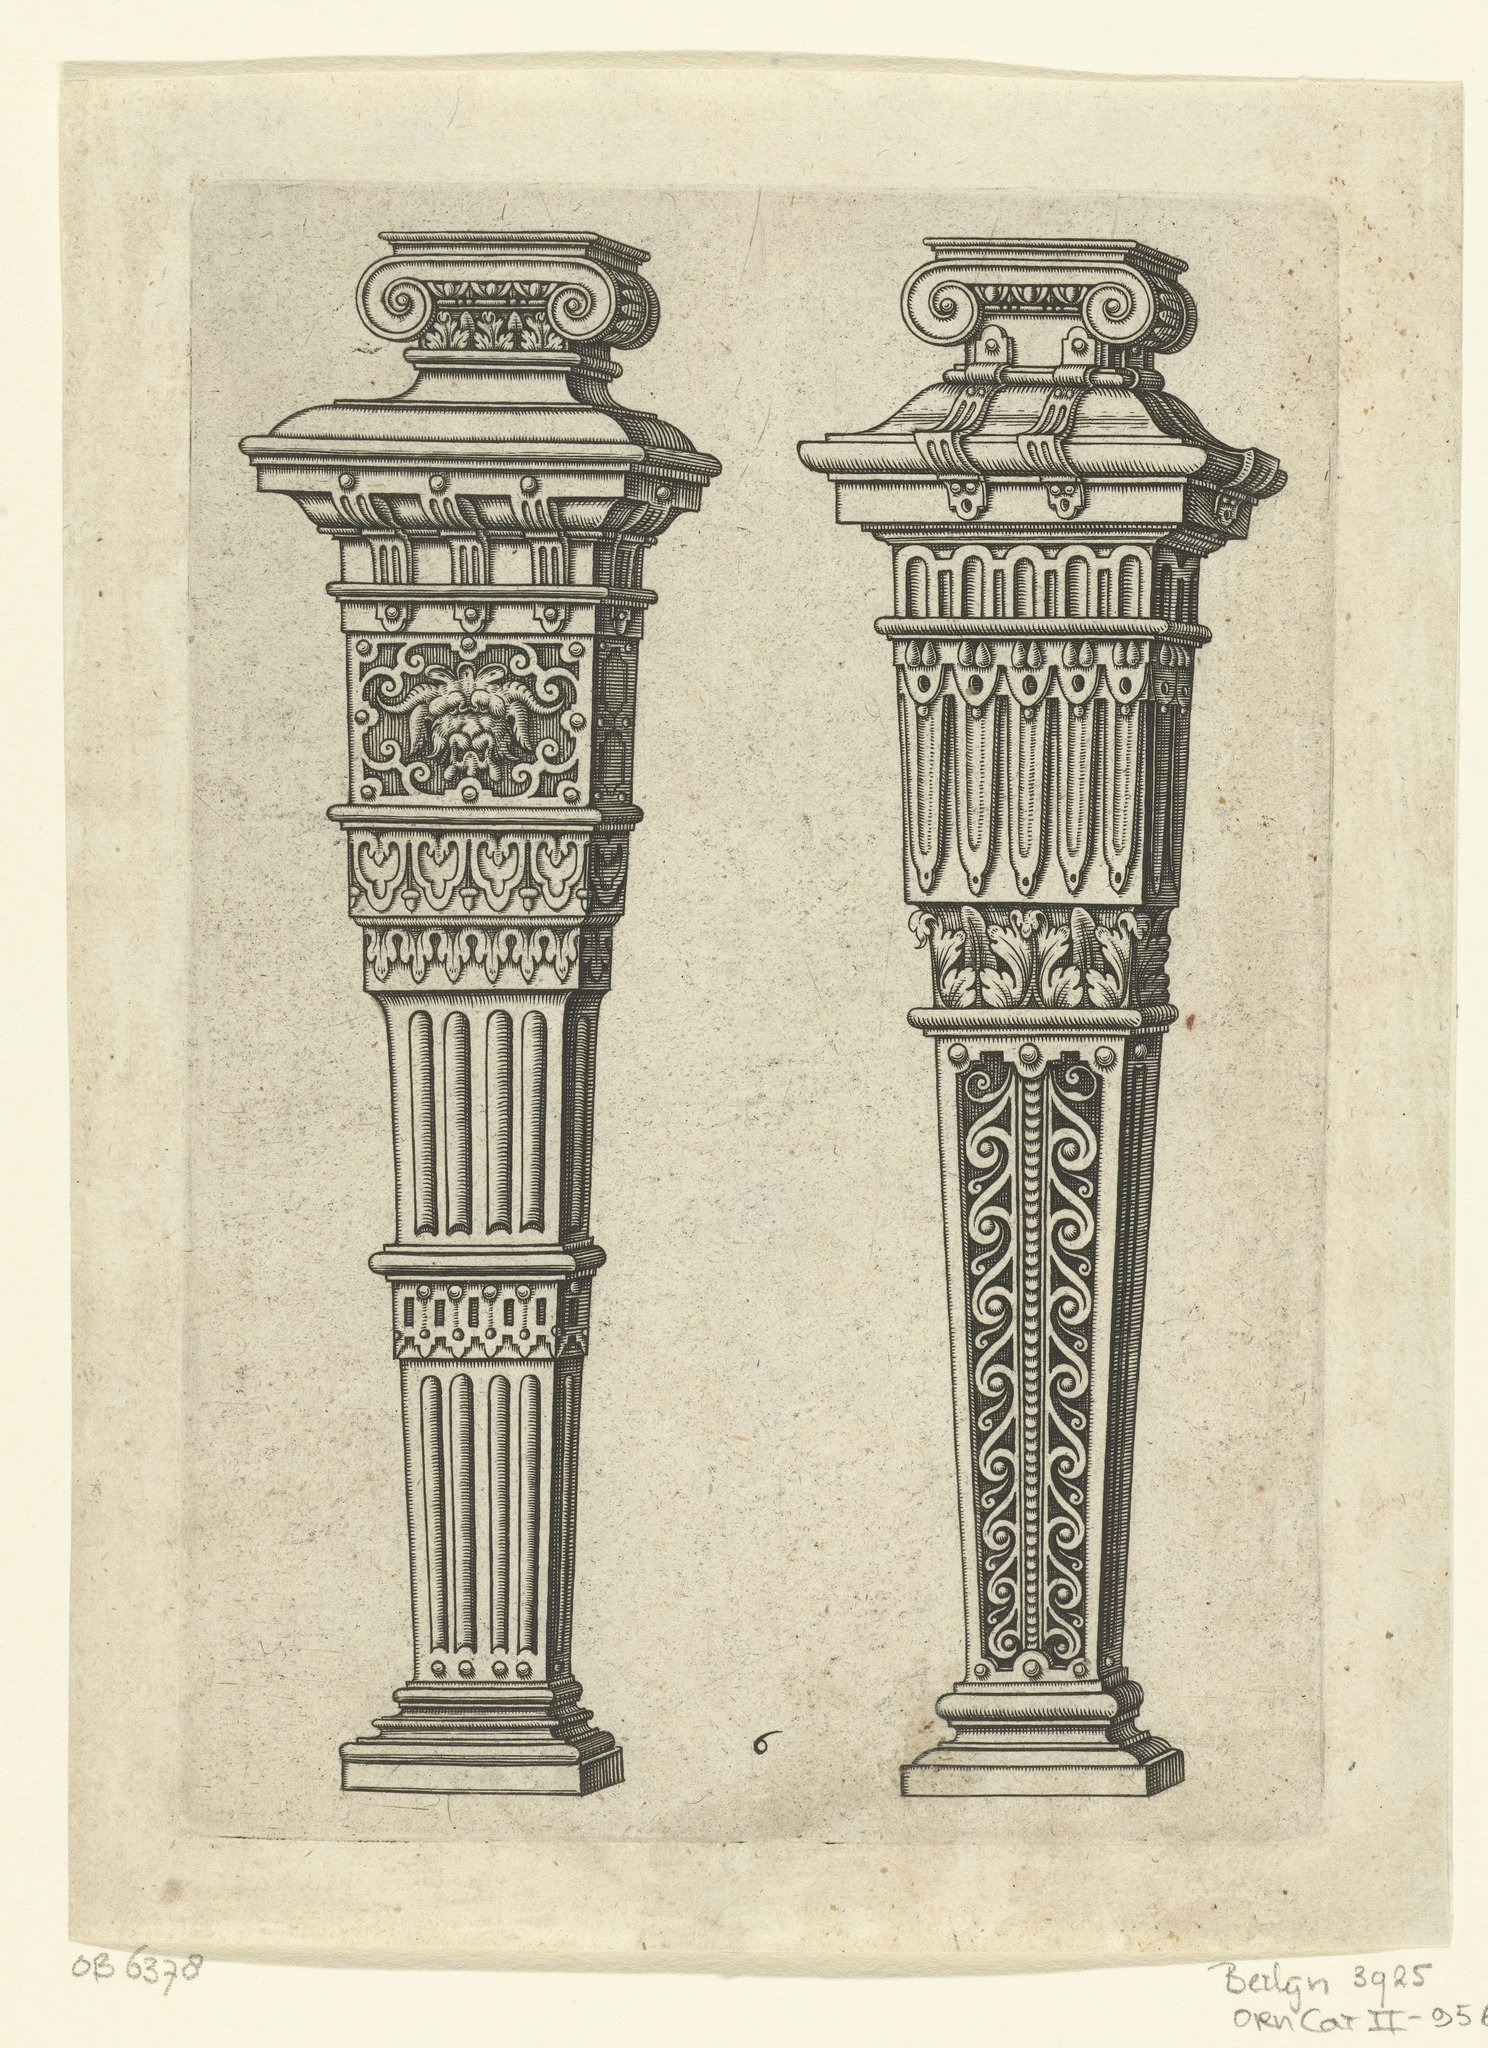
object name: ornament print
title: Twee Ionische termen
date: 1604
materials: paper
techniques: engraving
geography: amsterdam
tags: ionic order ~ architecture